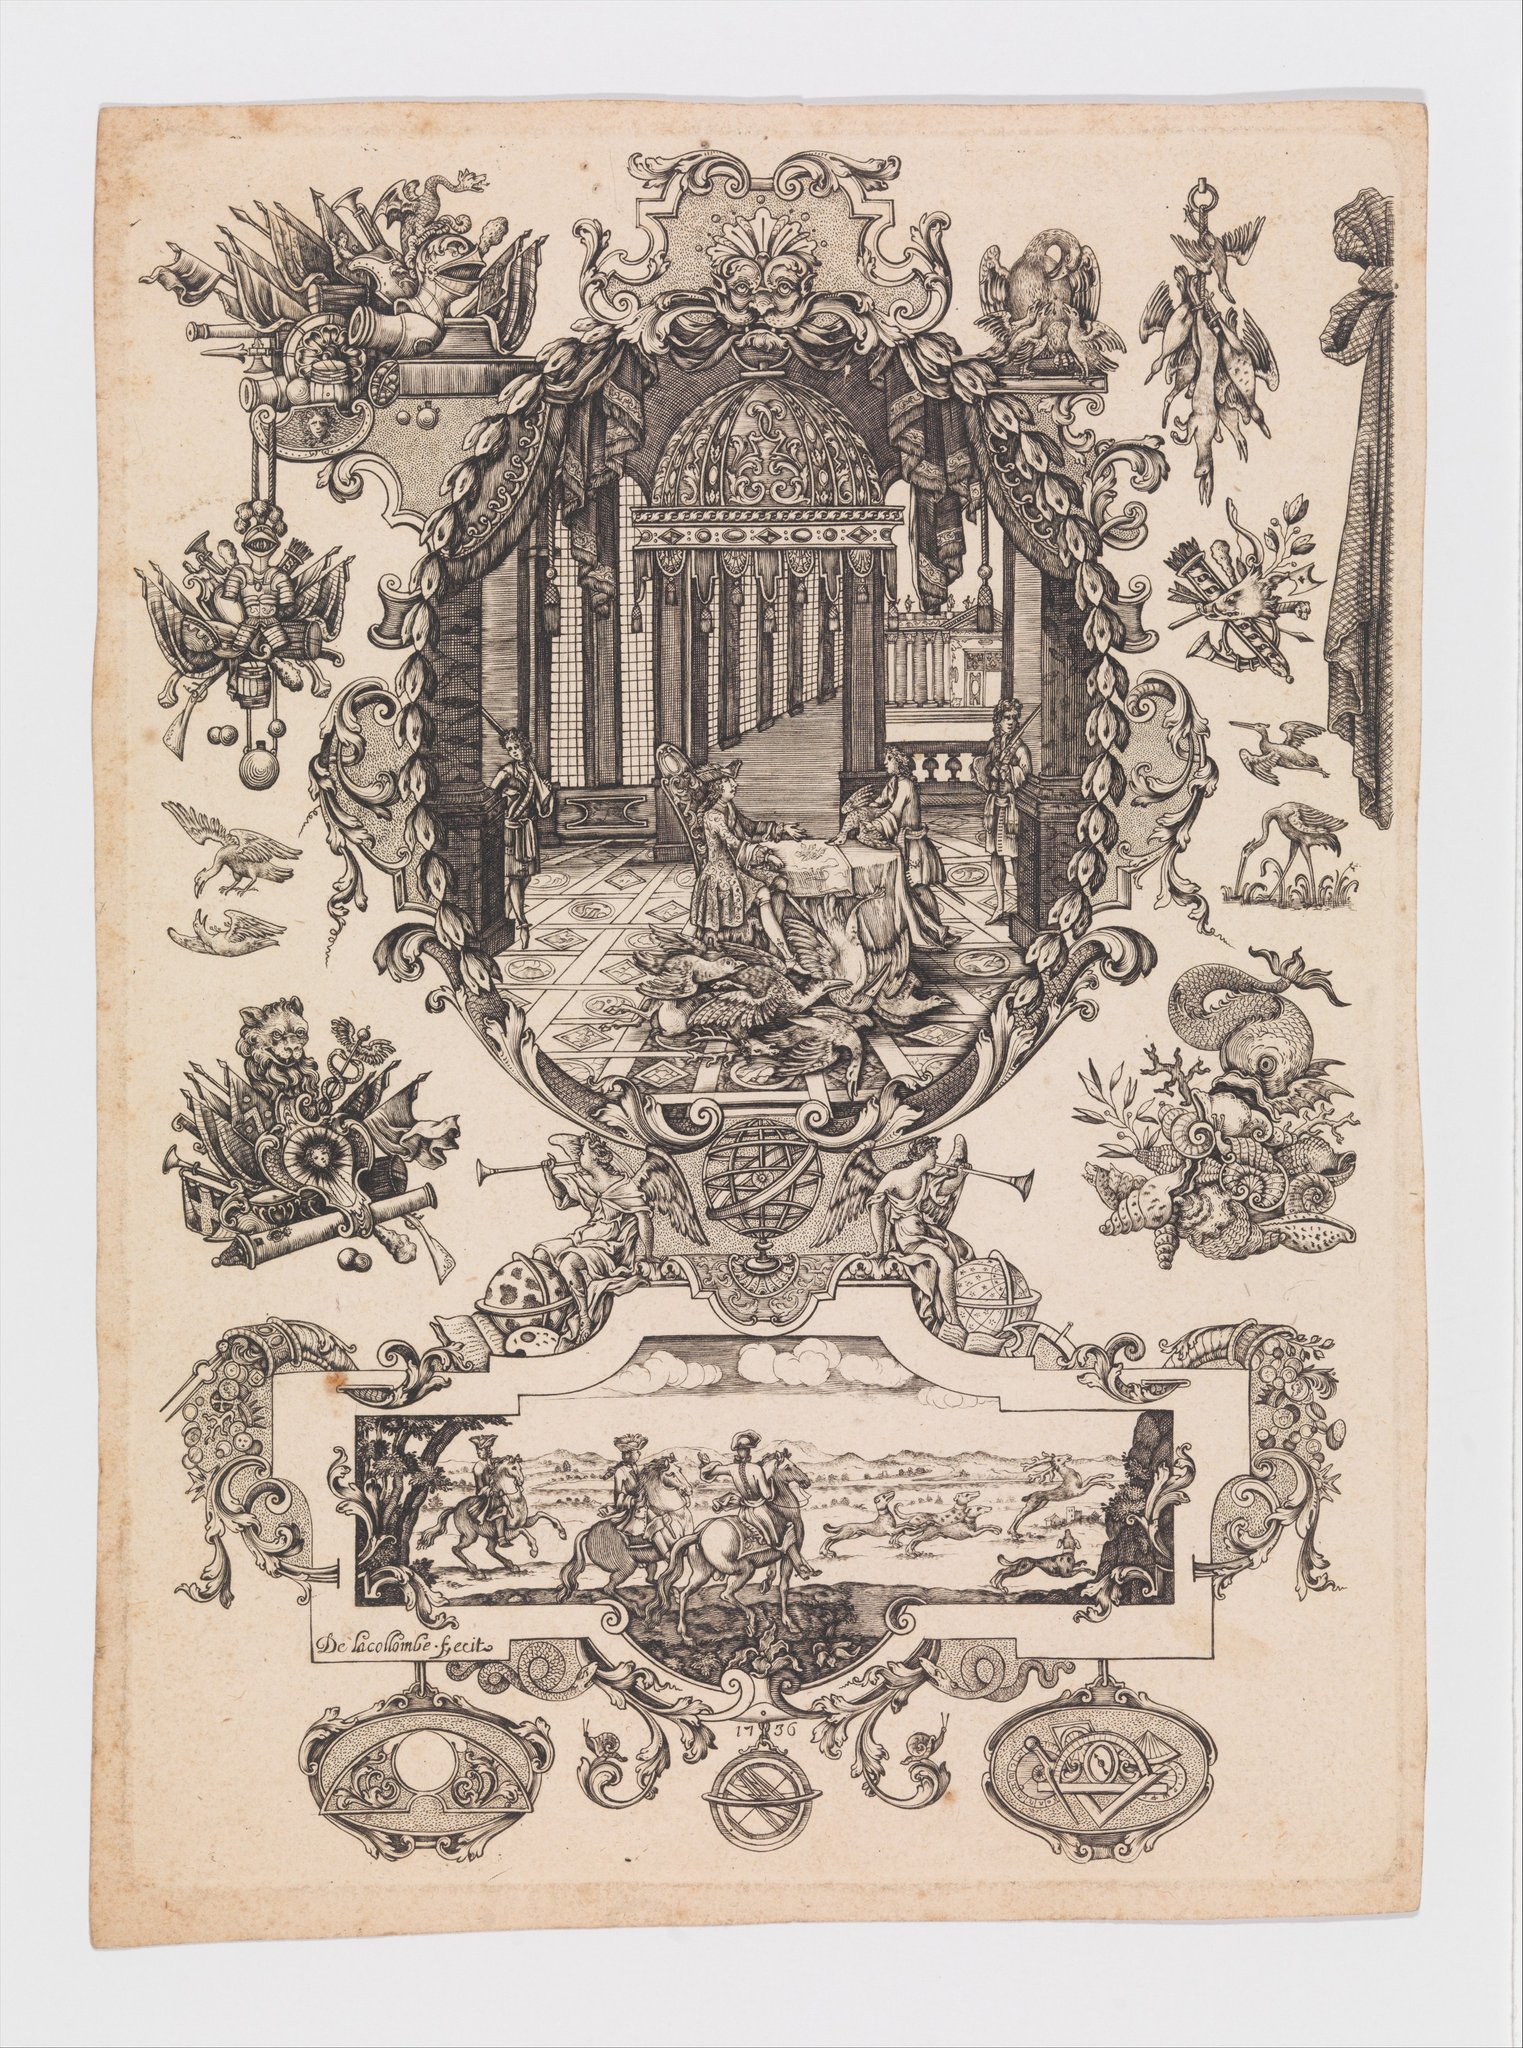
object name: ornament print from a firearm pattern book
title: Plate twelve from Nouveavx Desseins D'Arquebvseries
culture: french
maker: de lacollombe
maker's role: engraver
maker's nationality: french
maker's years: 1702-1736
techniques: engraving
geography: france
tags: birds,ornament,men